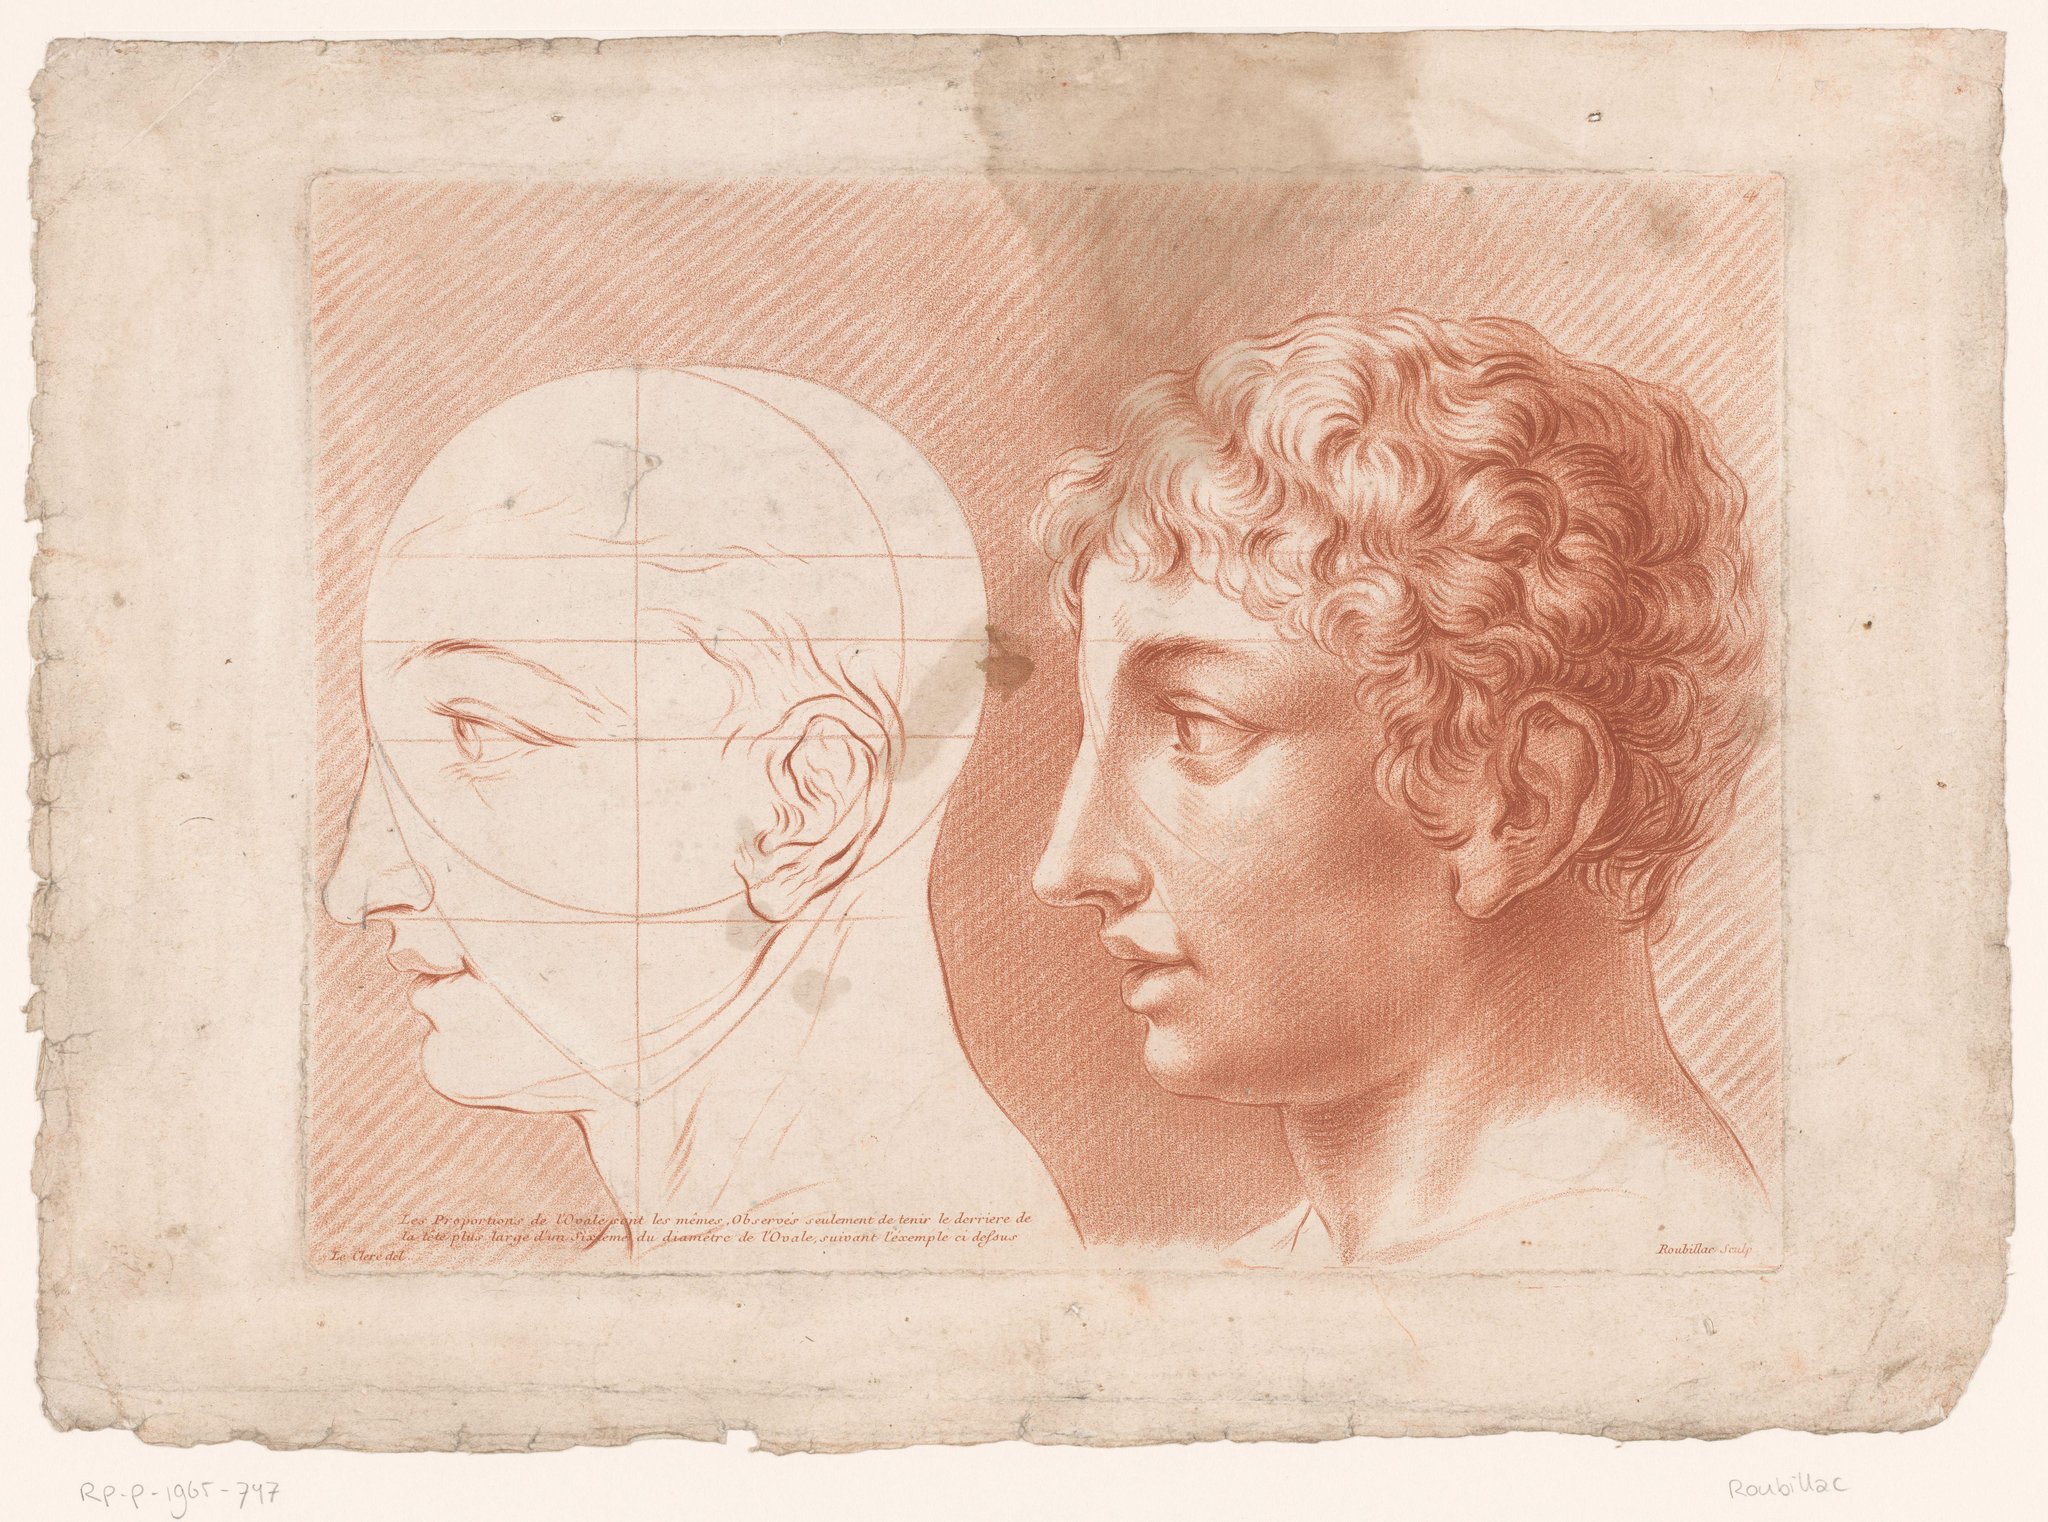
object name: print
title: Principes van het tekenen naar de natuur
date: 1749-1849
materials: paper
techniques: printmaking, etching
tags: drawing, sketch, head (human)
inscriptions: collector's mark: Lugt 2228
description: Onbekend tot welk deel van 'Principes du Dessin d'après Nature' deze prent behoort.